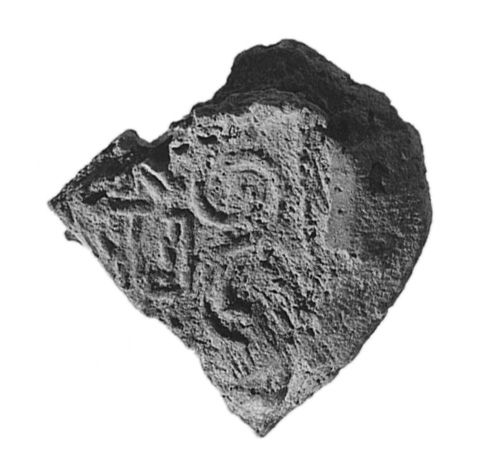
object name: sealing fragment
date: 2030-1640 BCE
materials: clay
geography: egypt